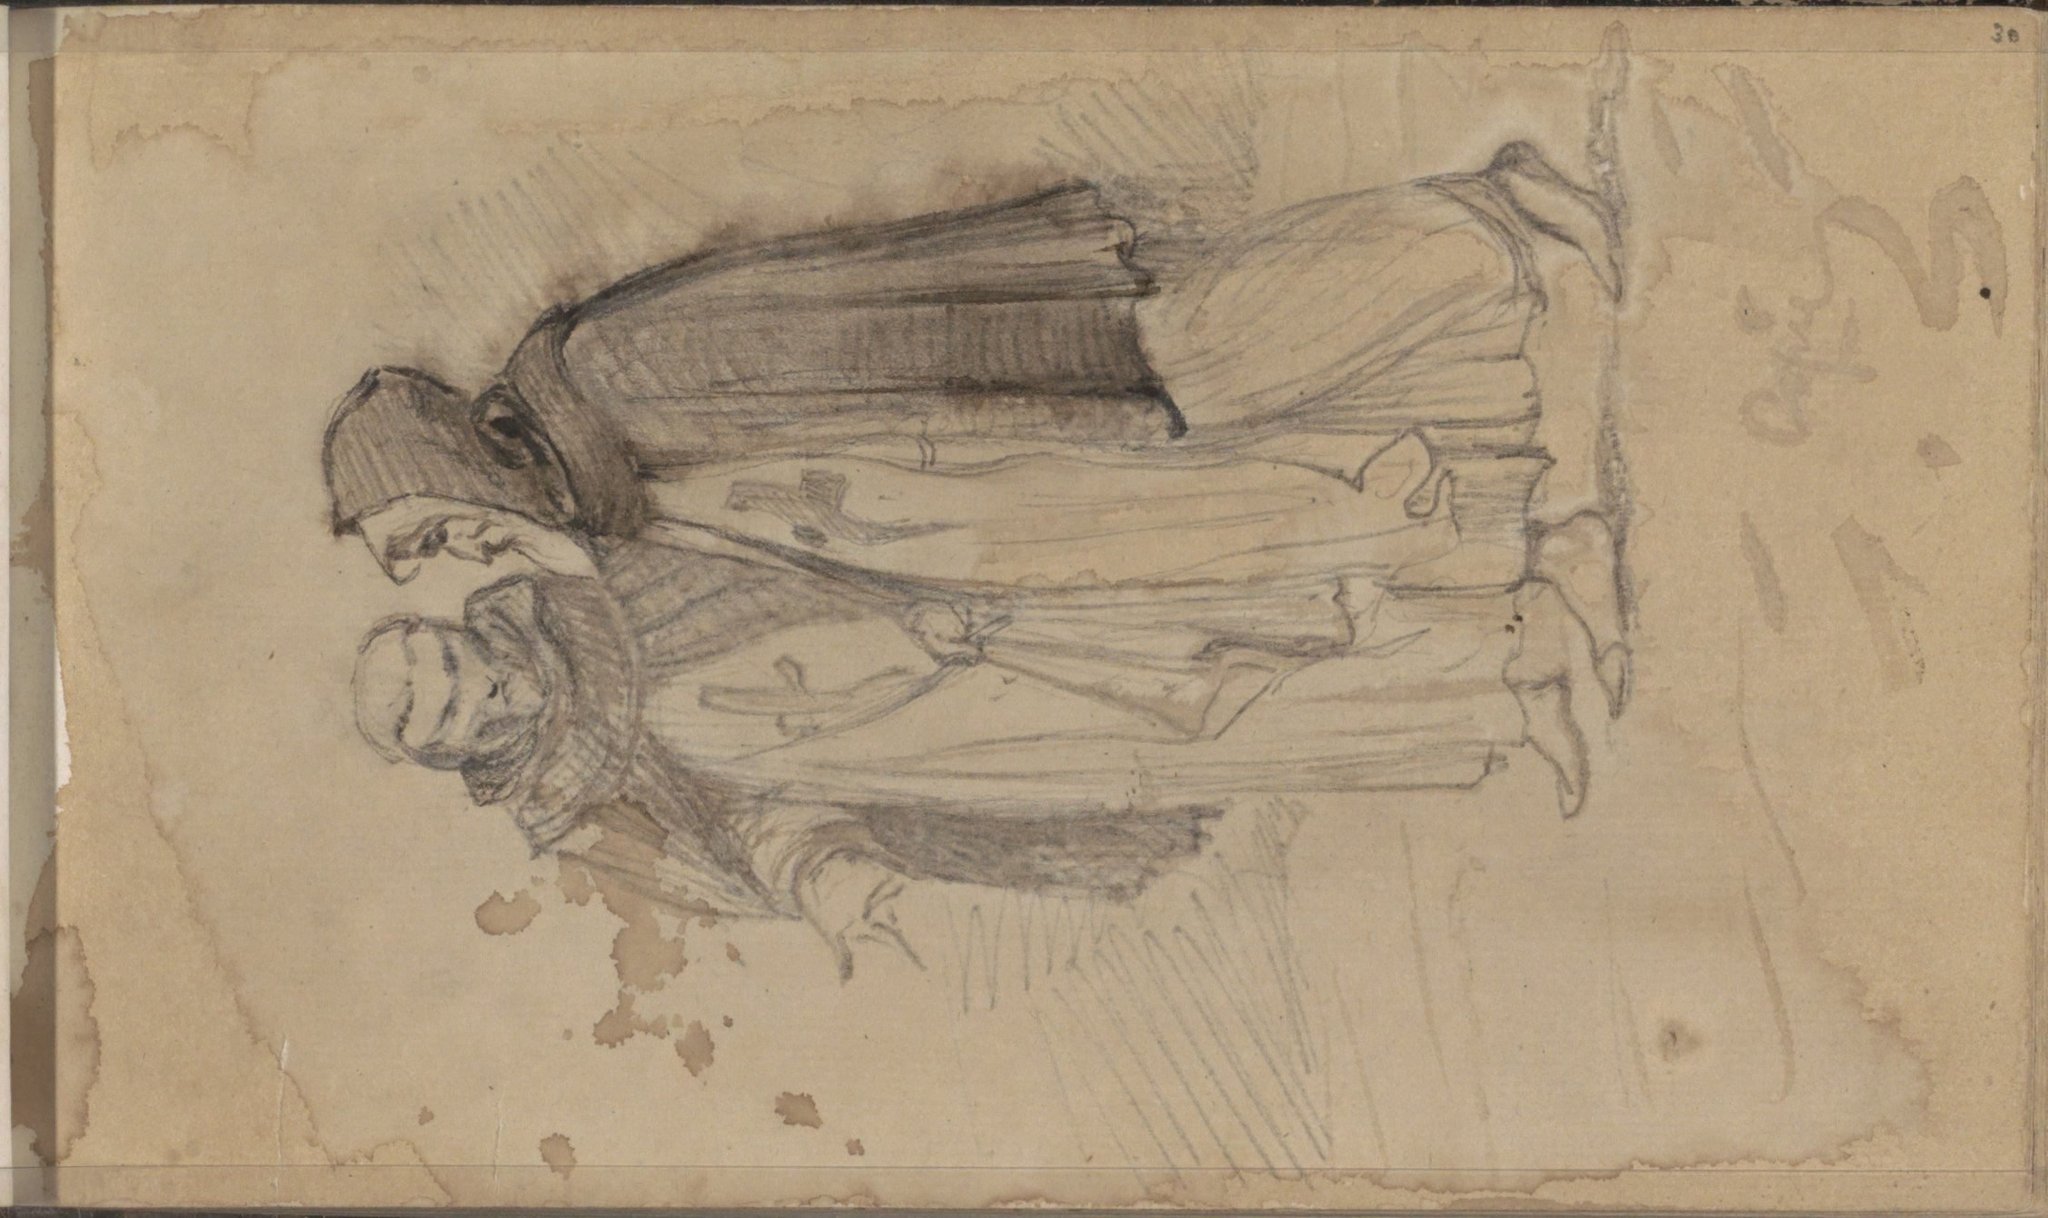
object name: sketchbook leaf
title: Kopie naar een voorstelling met twee monniken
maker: johannes tavenraat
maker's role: draughtsman, painter, print maker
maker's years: 1809-1881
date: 1864-1880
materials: ink, paper, pencil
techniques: brush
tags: monk(s), friar(s)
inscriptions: annotation: ‘Copie’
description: Blad 30 recto uit een schetsboek met 98 bladen.